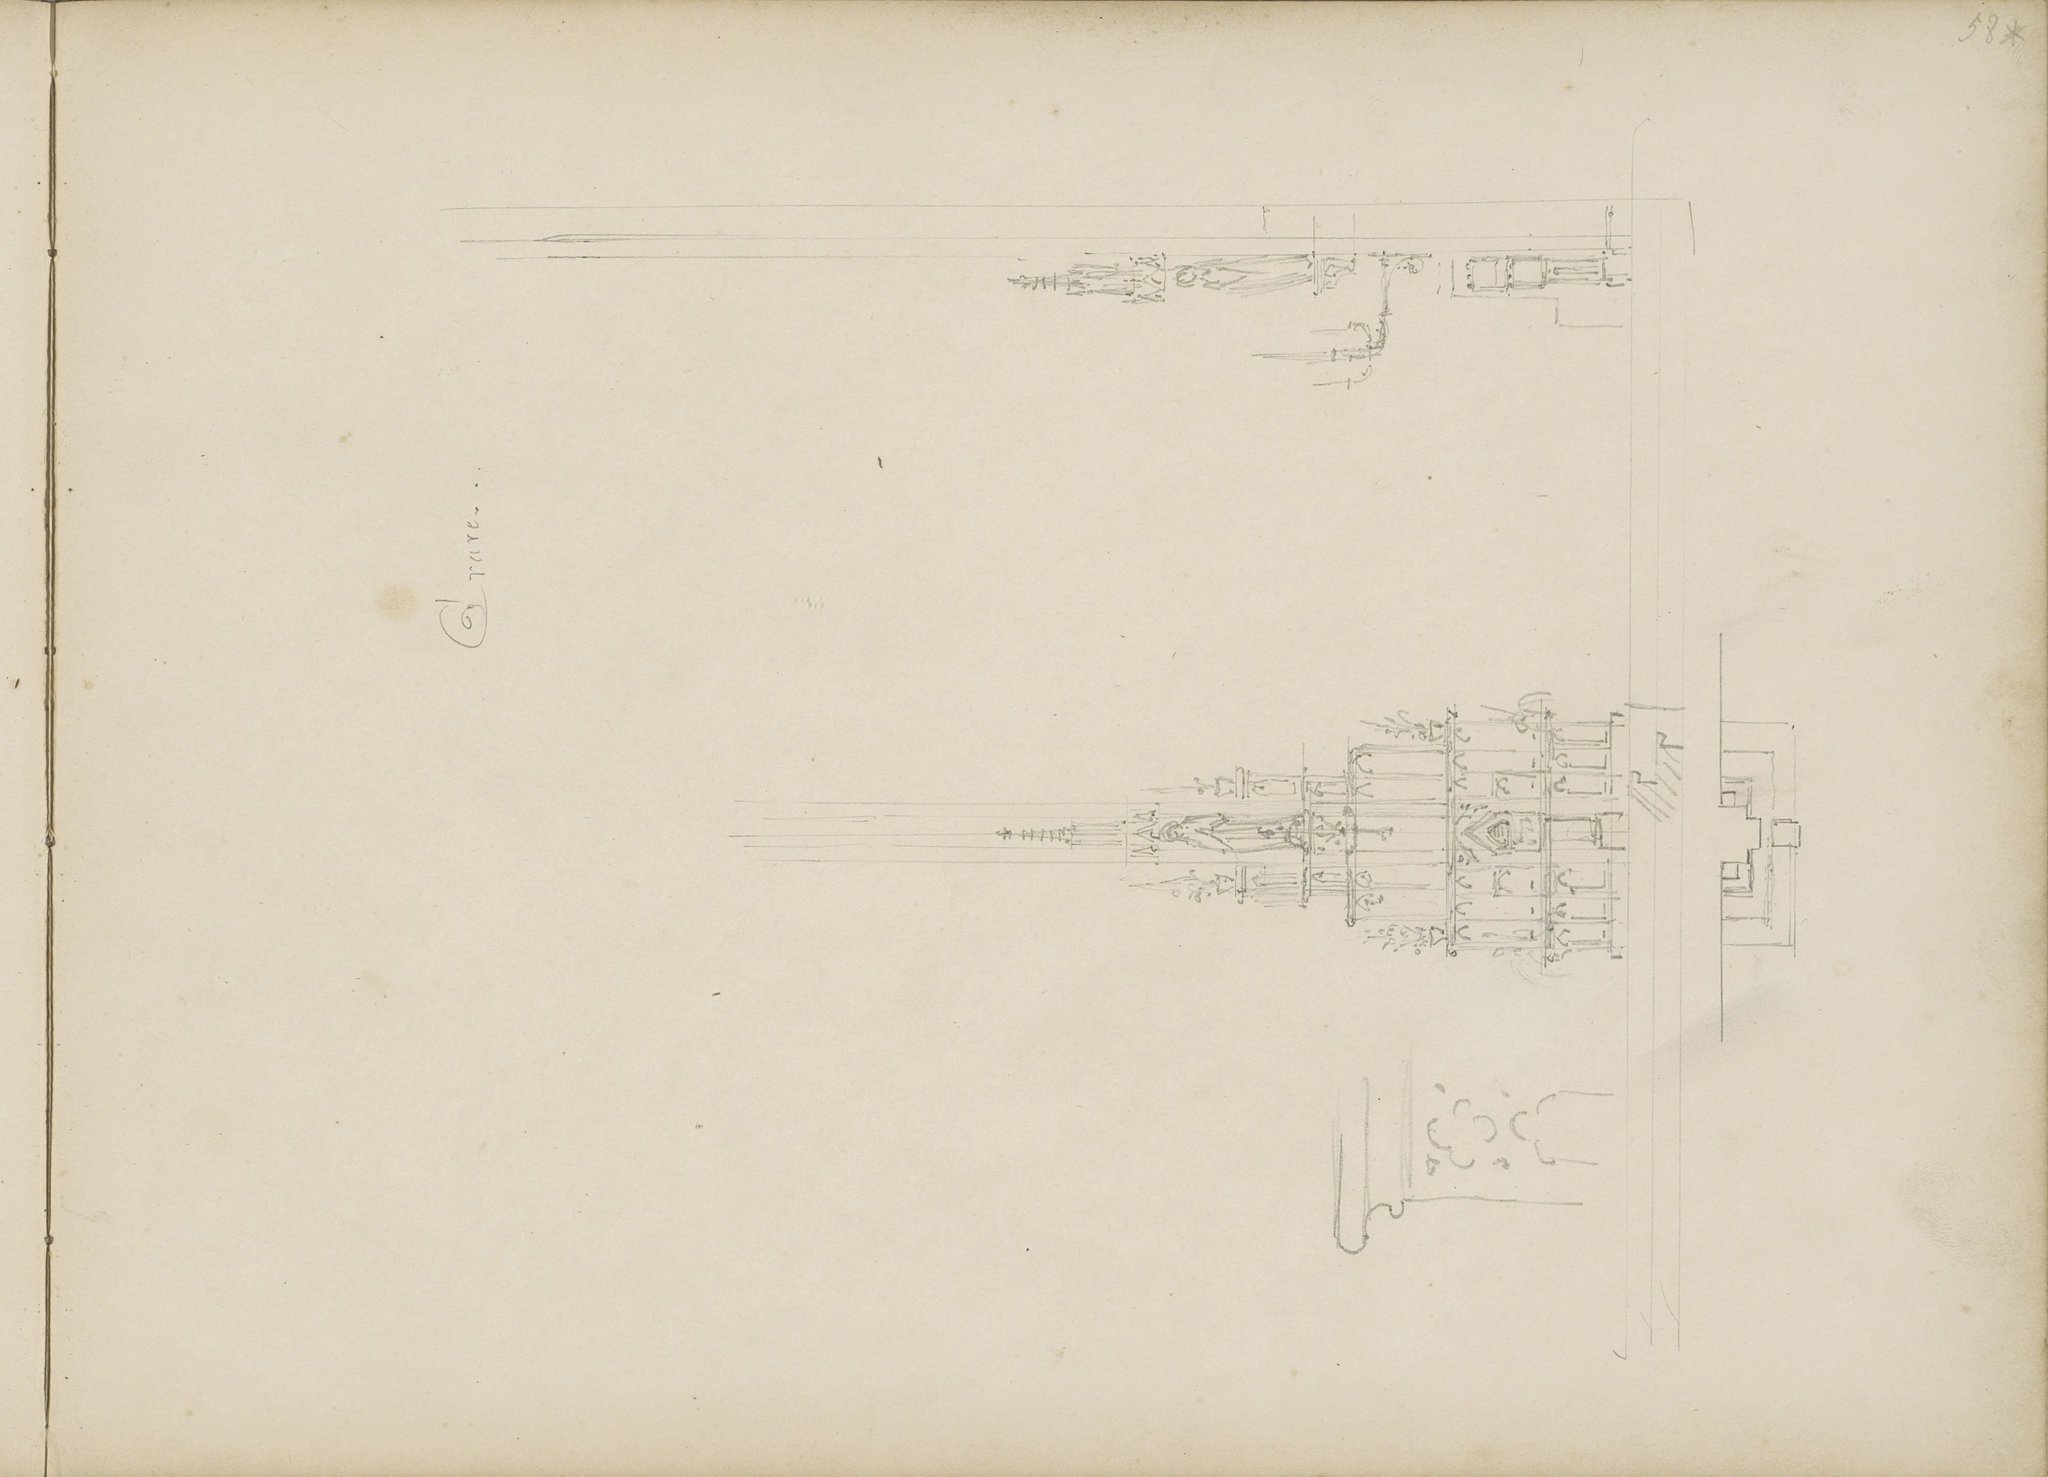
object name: sketchbook leaf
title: Voor- en zijaanzicht van een altaar, Grave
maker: pierre joseph hubert cuypers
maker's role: draughtsman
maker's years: 1827-1921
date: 1857-1859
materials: paper, pencil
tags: altar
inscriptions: annotation: ‘Grave’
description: Recto van een foutief genummerd blad (58*) tussen blad 58 en 59 uit een schetsboek met 77 bladen.